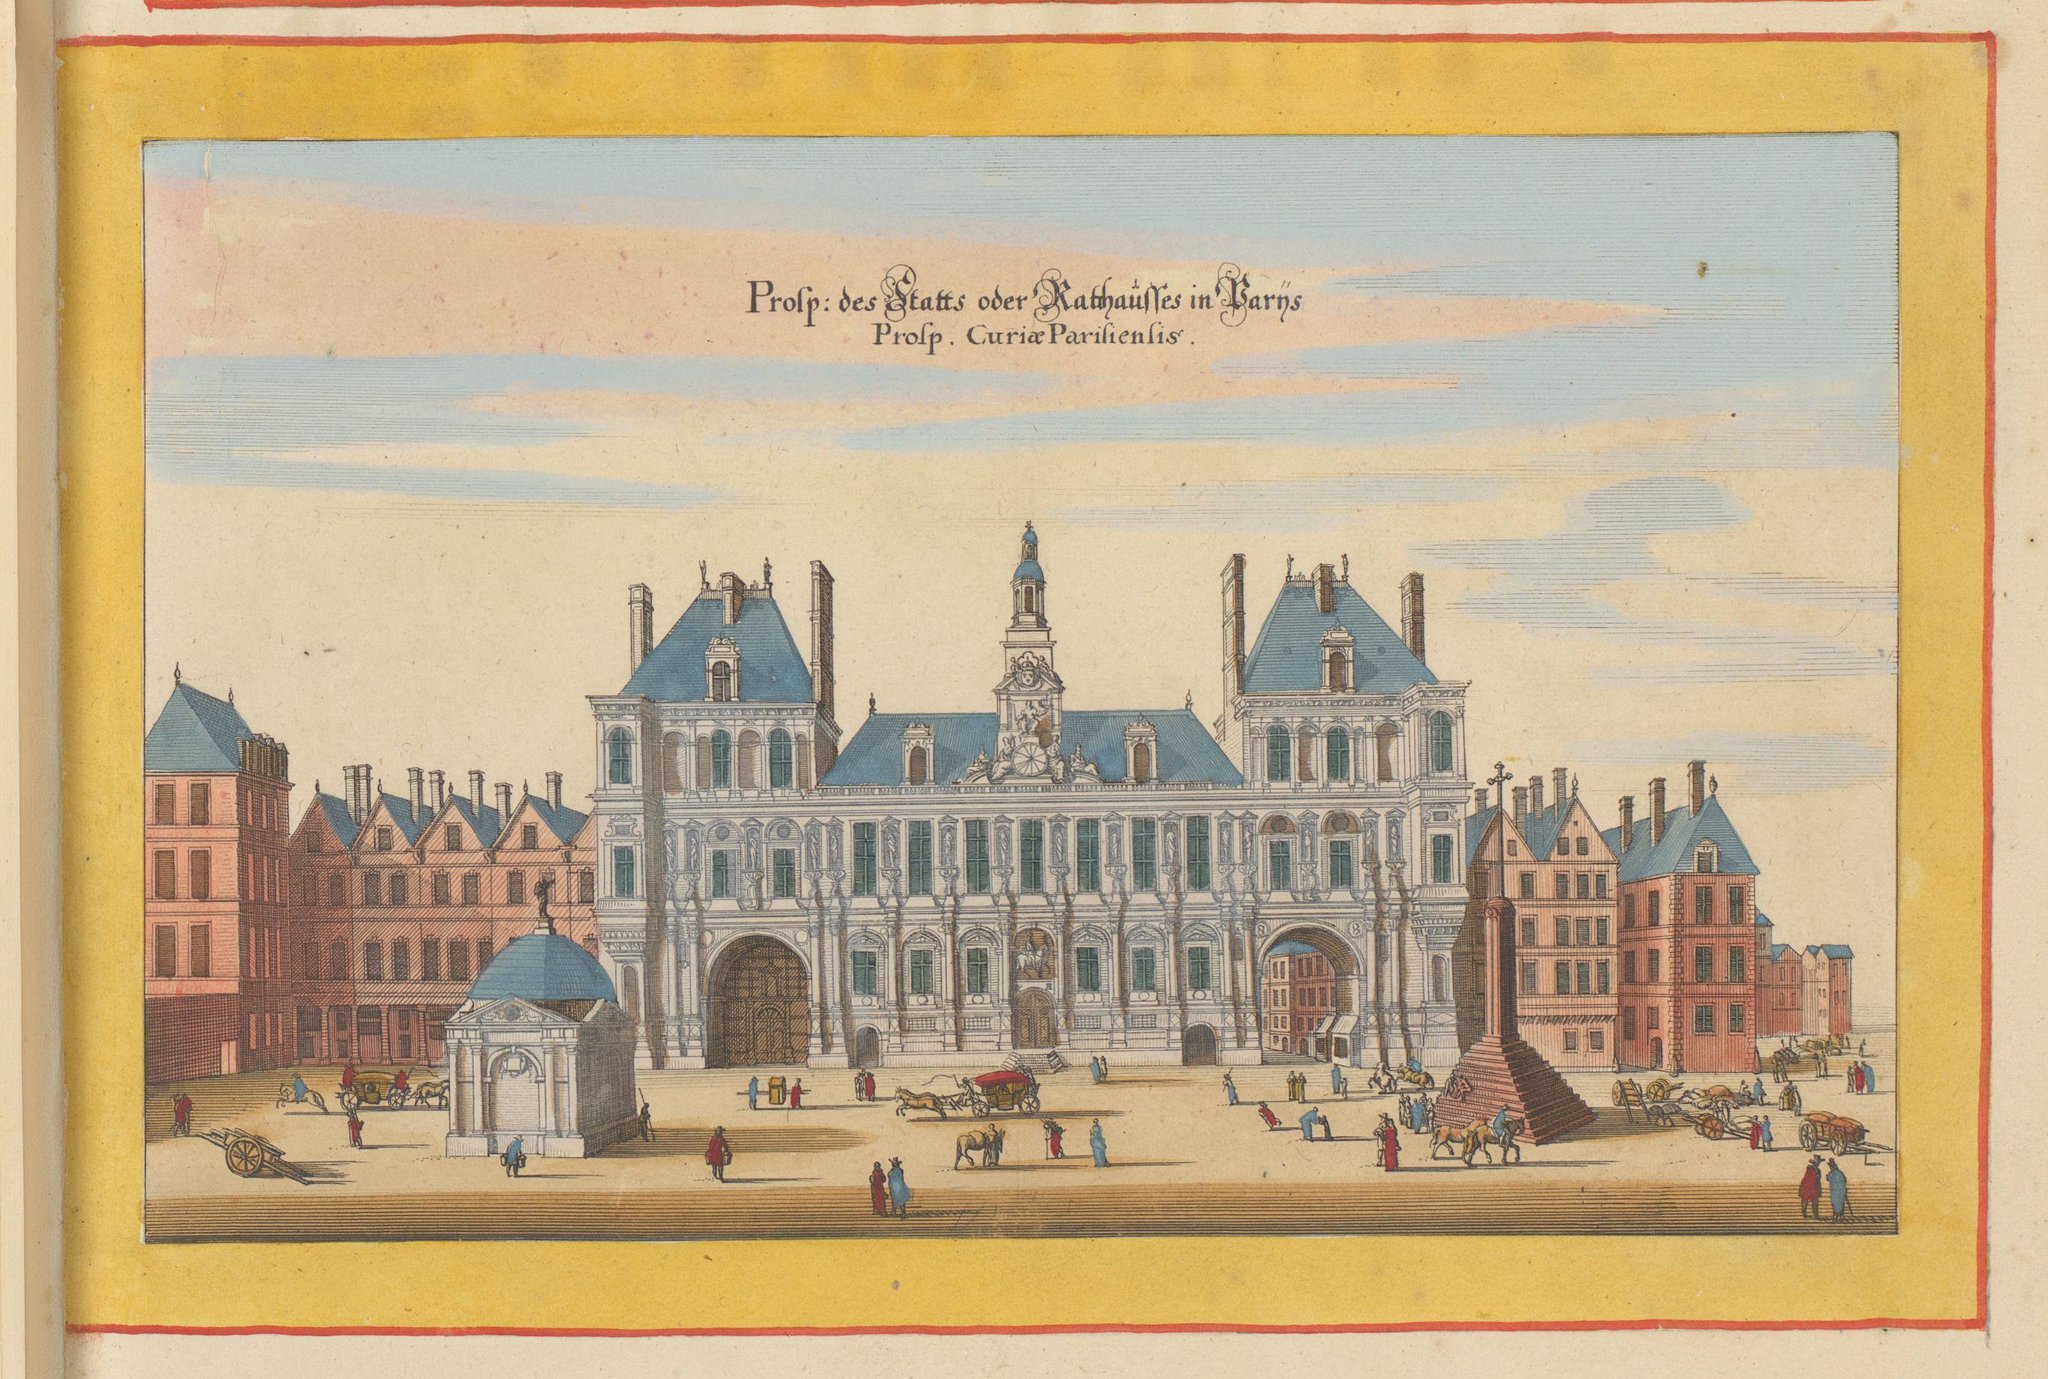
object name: album leaf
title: Stadhuis van Parijs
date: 1655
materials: paper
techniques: engraving, etching, hand coloring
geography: the hague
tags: townhall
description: Prent origineel vervaardigd als boekillustratie voor: Zeiller, Martin. Topographia Galliae, oder Beschreibung und Contrafaitung der vornehmbsten und bekantisten Oerter in dem mächtigen und grossen Königreich Frankreich, 13 delen. Frankfurt am Main: Caspar Merian, 1655-1661. De prent werd voor het eerst gepubliceerd in deel 1: Topographia Galliae, 1655.